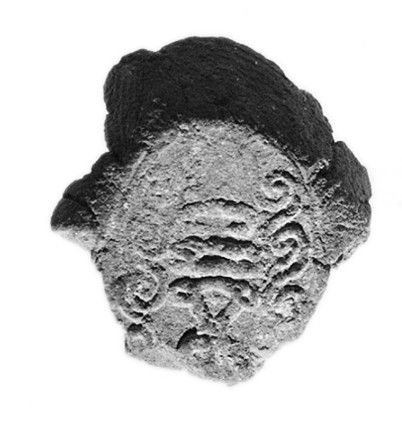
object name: sealing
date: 1981-1640 BCE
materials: mud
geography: egypt